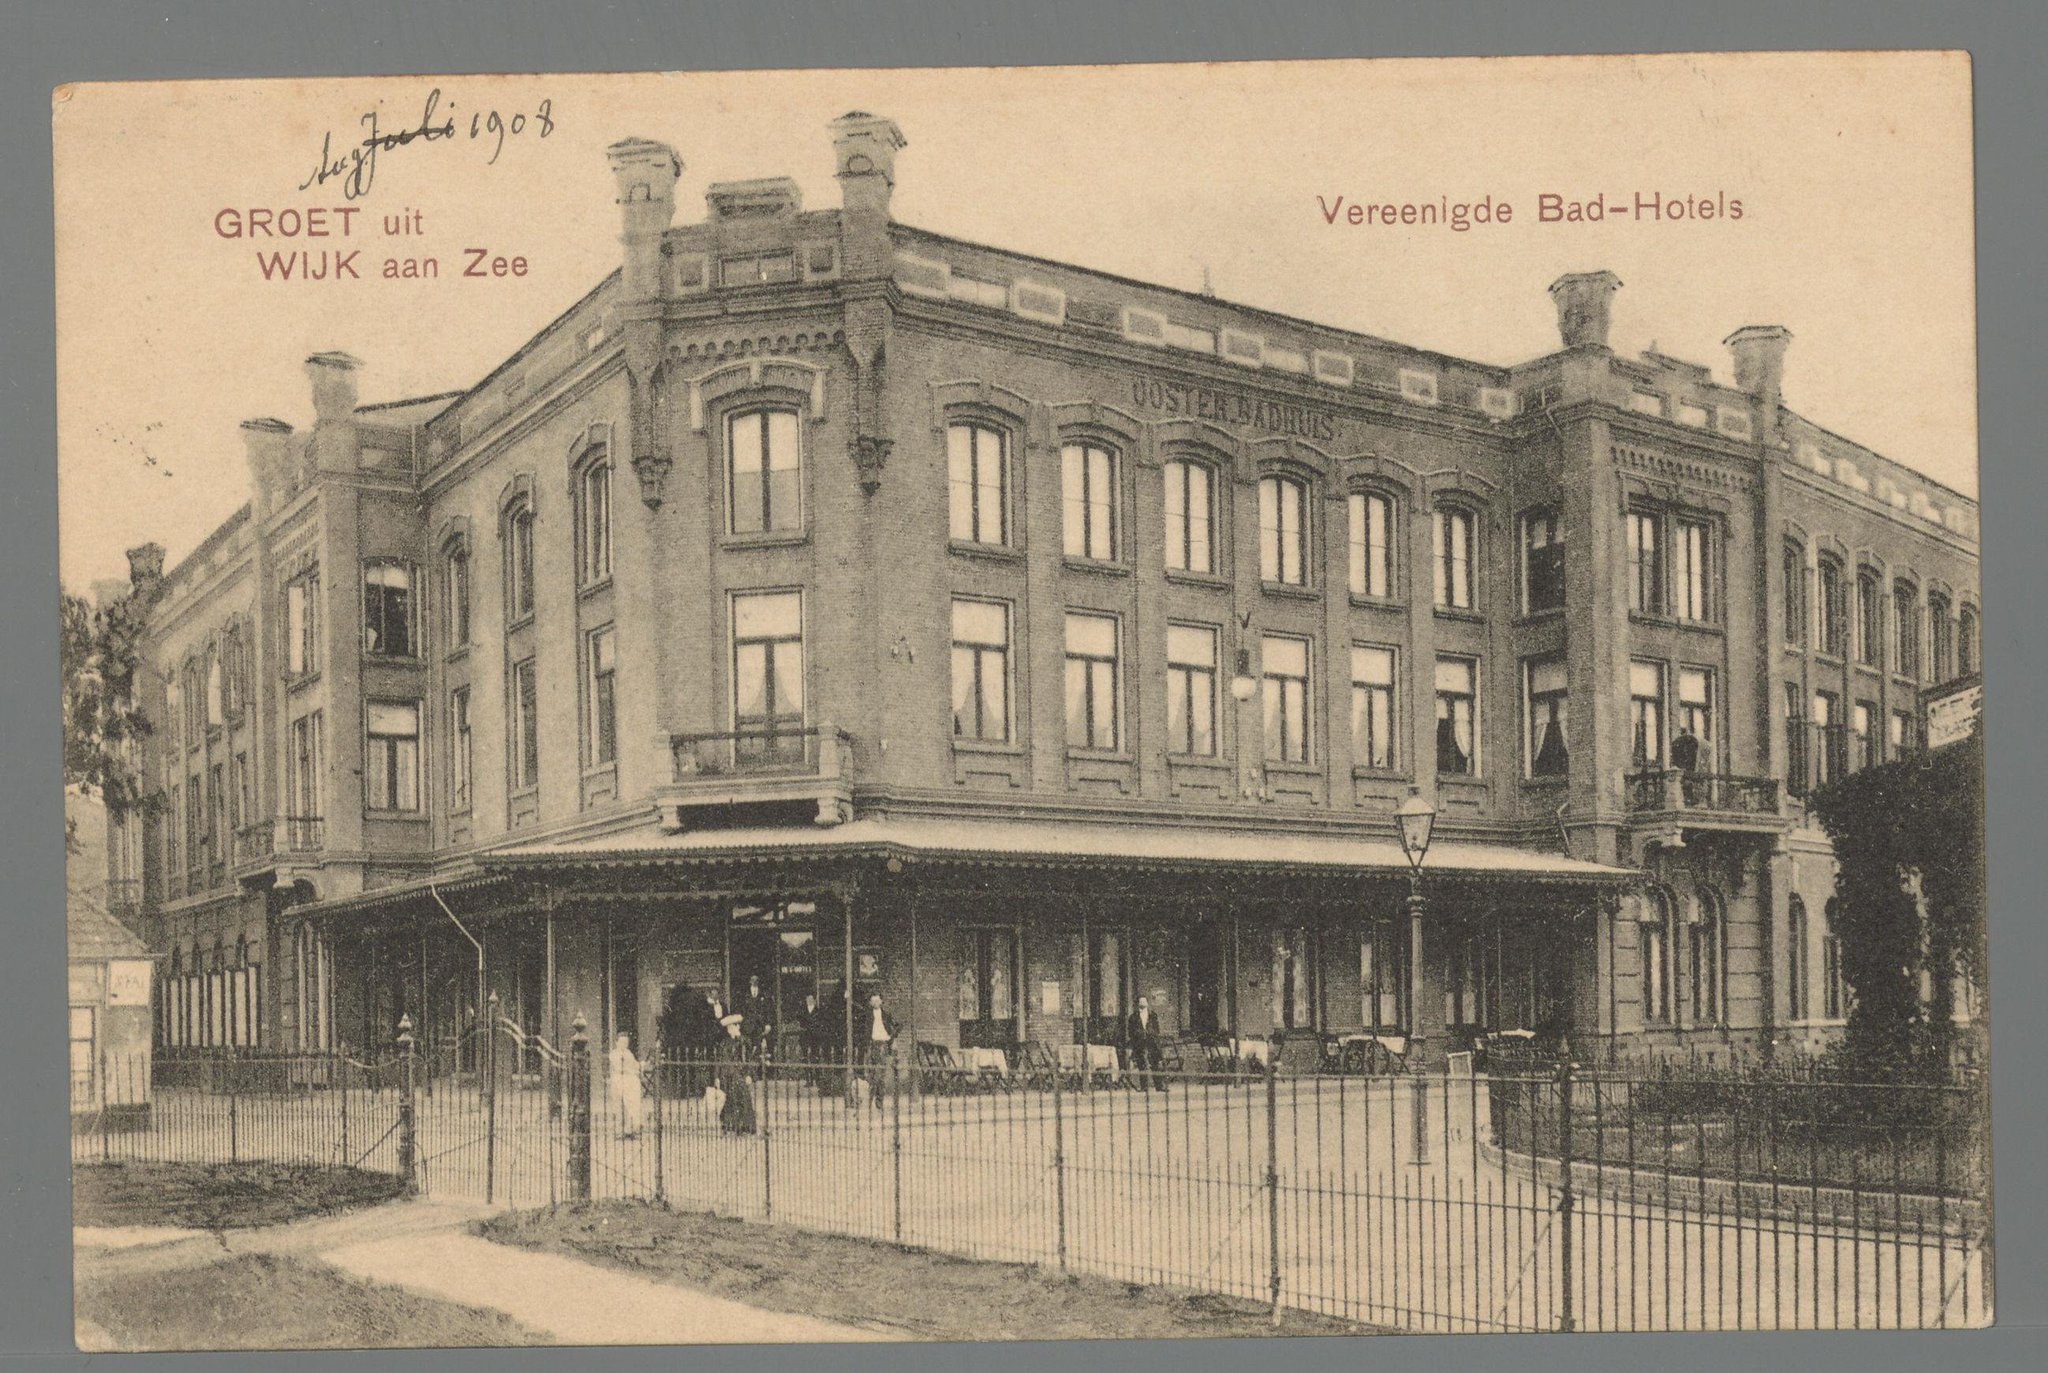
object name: photomechanical print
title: Groet uit Wijk aan Zee. Vereenigde Bad-Hotels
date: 1905-1908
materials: cardboard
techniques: photograph, writing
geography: wijk aan zee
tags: hotel, hostelry, inn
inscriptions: postage stamp